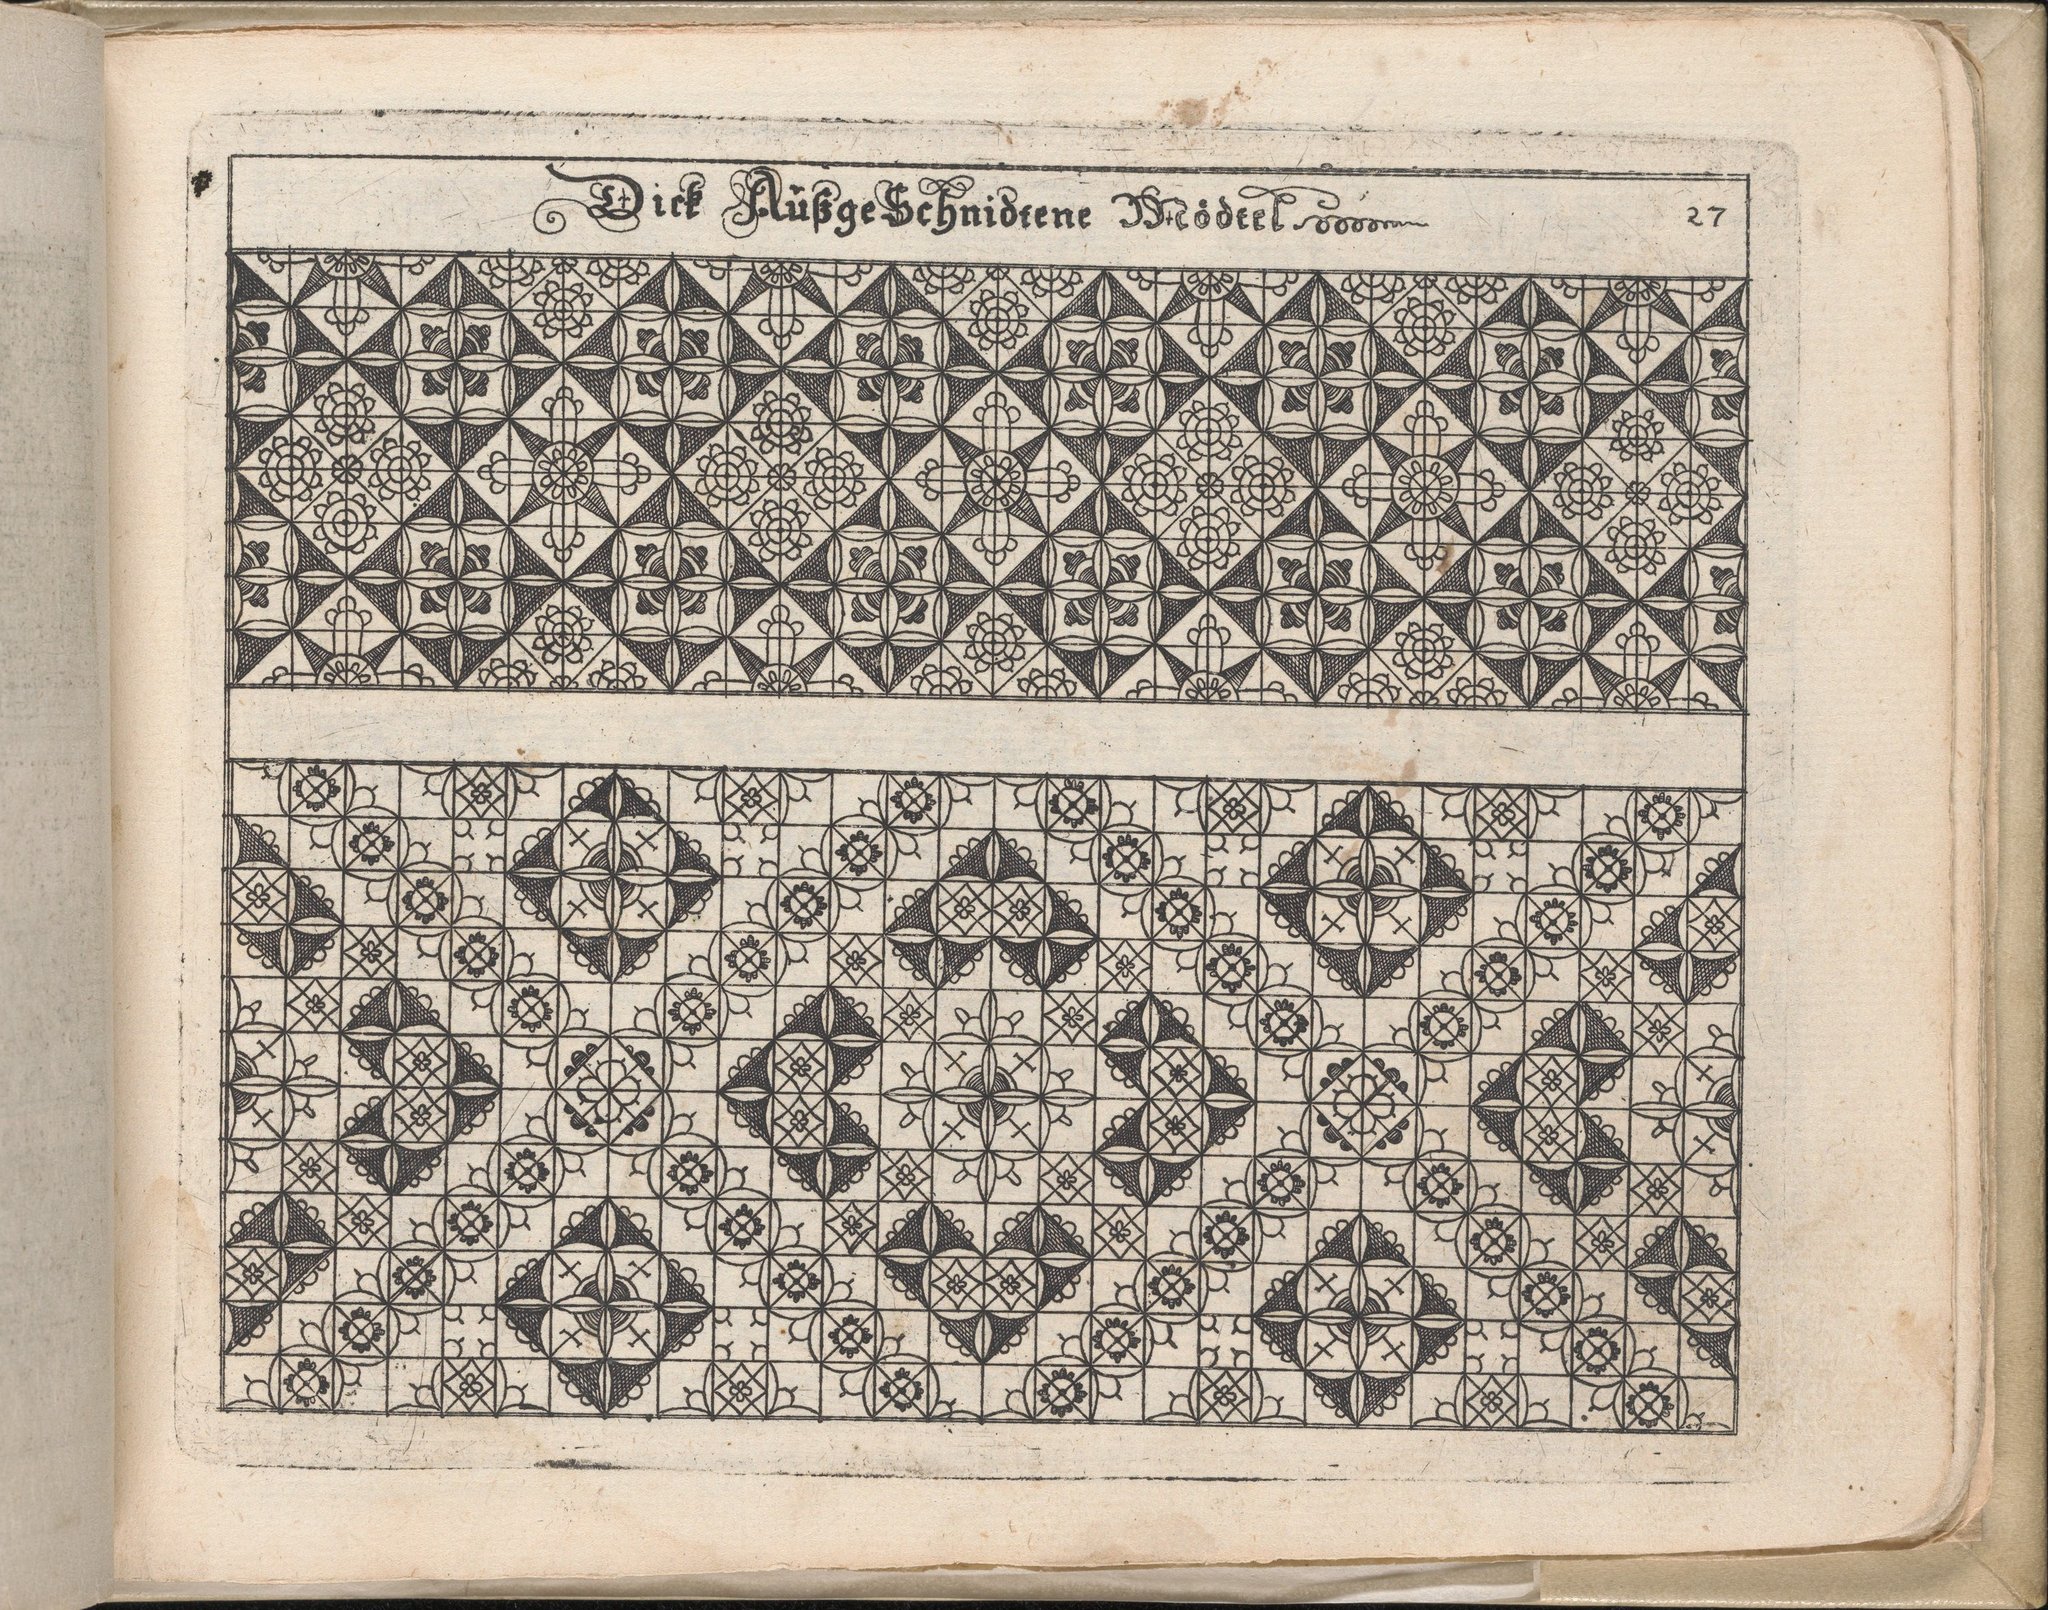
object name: book print ornament architecture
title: Schön Neues Modelbuch (Page 32 recto)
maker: johann sibmacher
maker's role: designer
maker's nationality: german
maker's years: 1590-1611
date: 1597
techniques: etching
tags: ornament